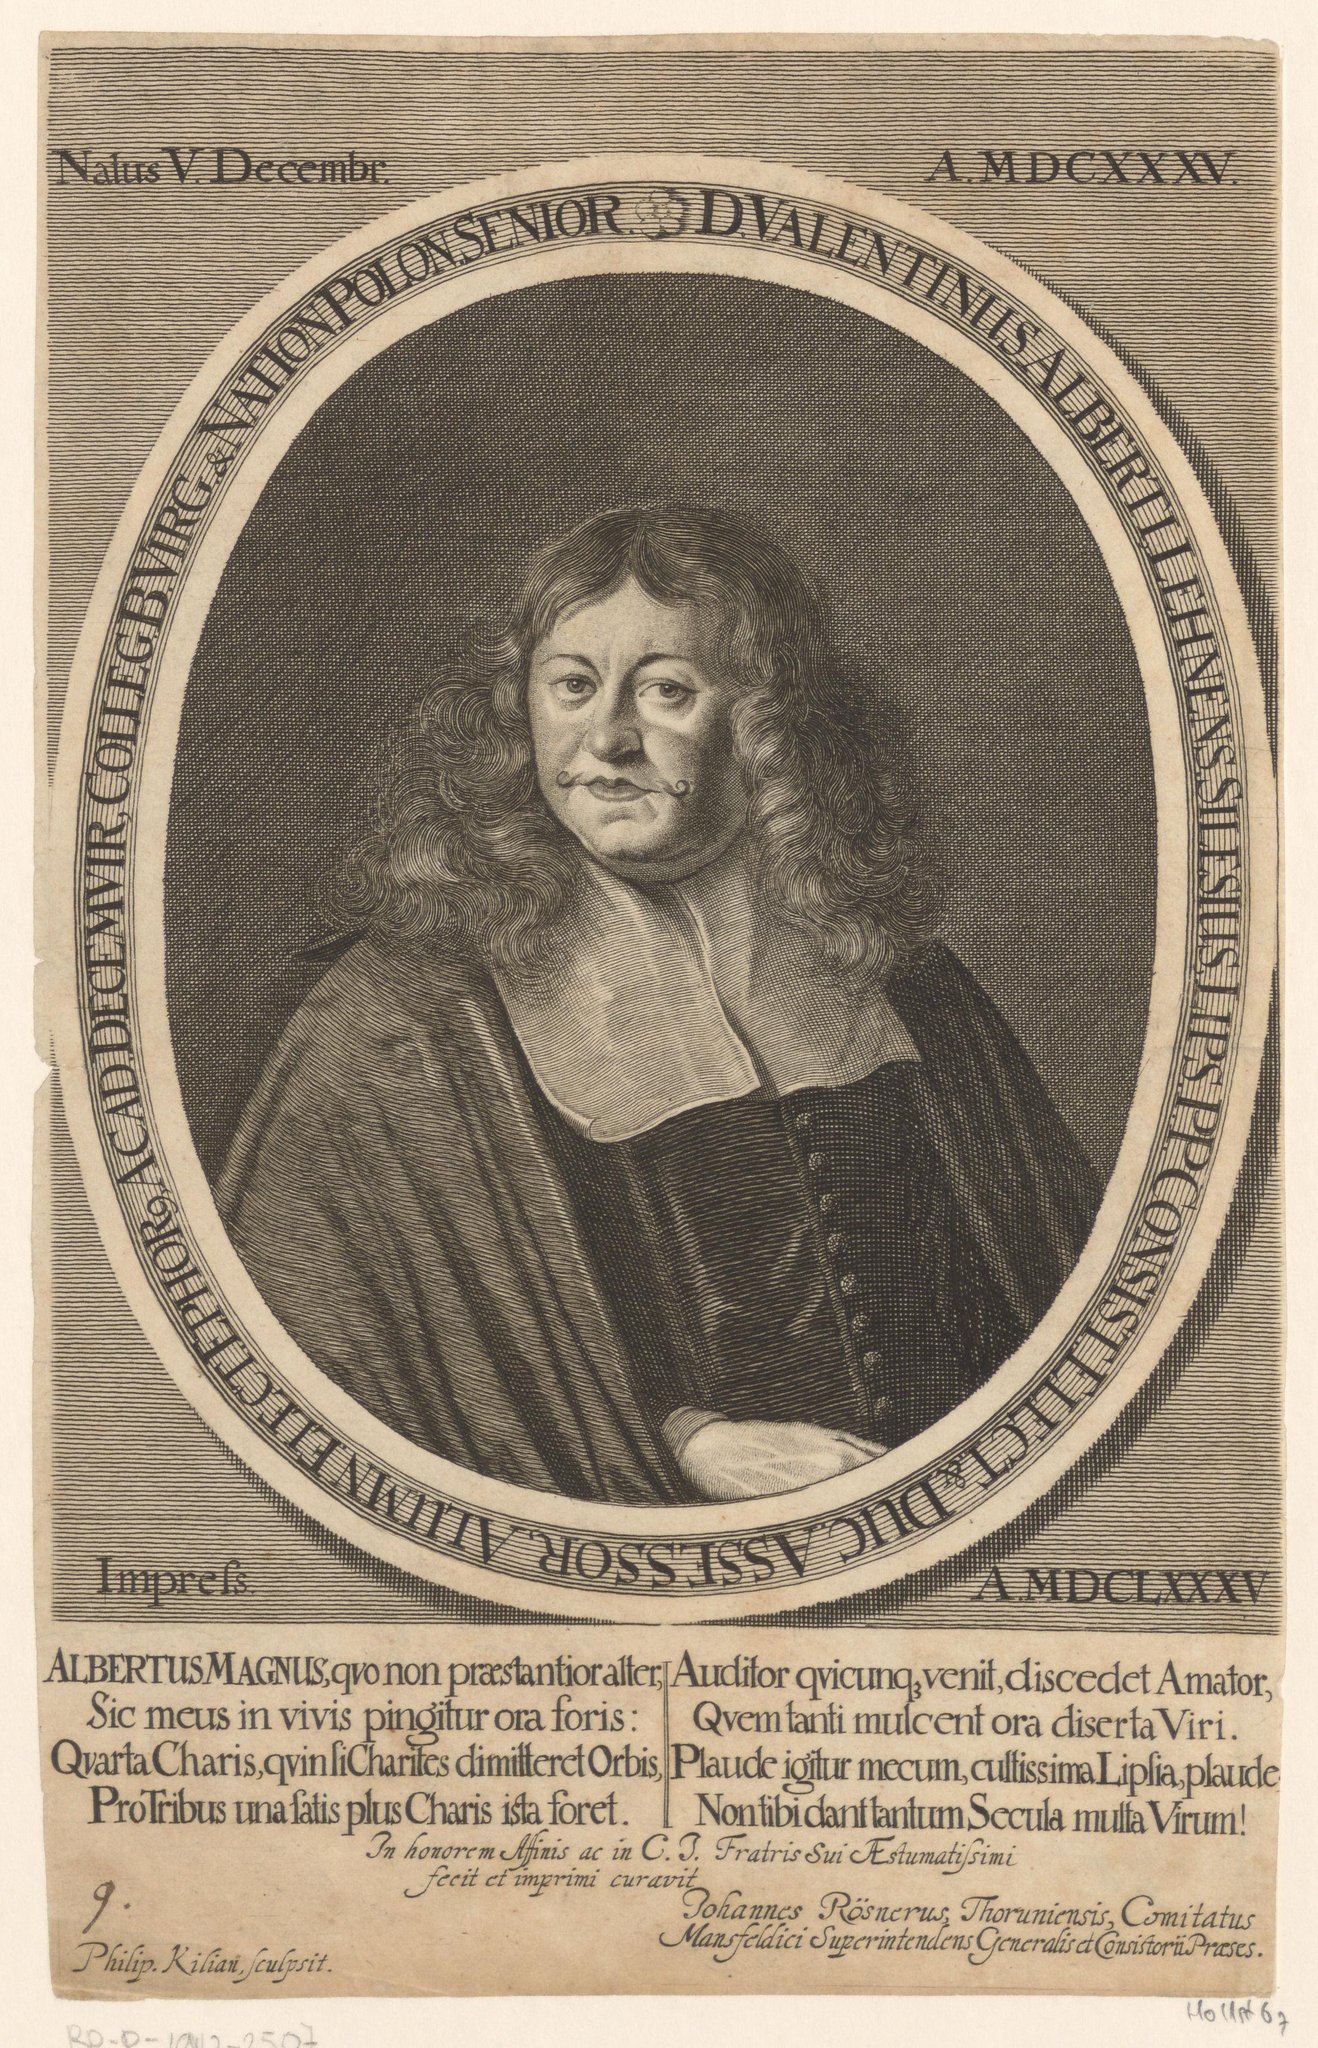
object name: print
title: Portret van Valentin Alberti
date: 1685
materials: paper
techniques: engraving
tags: valentin alberti, philology (+ portrait of scholar, scientist), theologian, historical persons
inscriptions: annotation: ‘9.’, collector's mark: Lugt 2228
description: Tekst in het Latijn in de omlijsting en in de ondermarge.